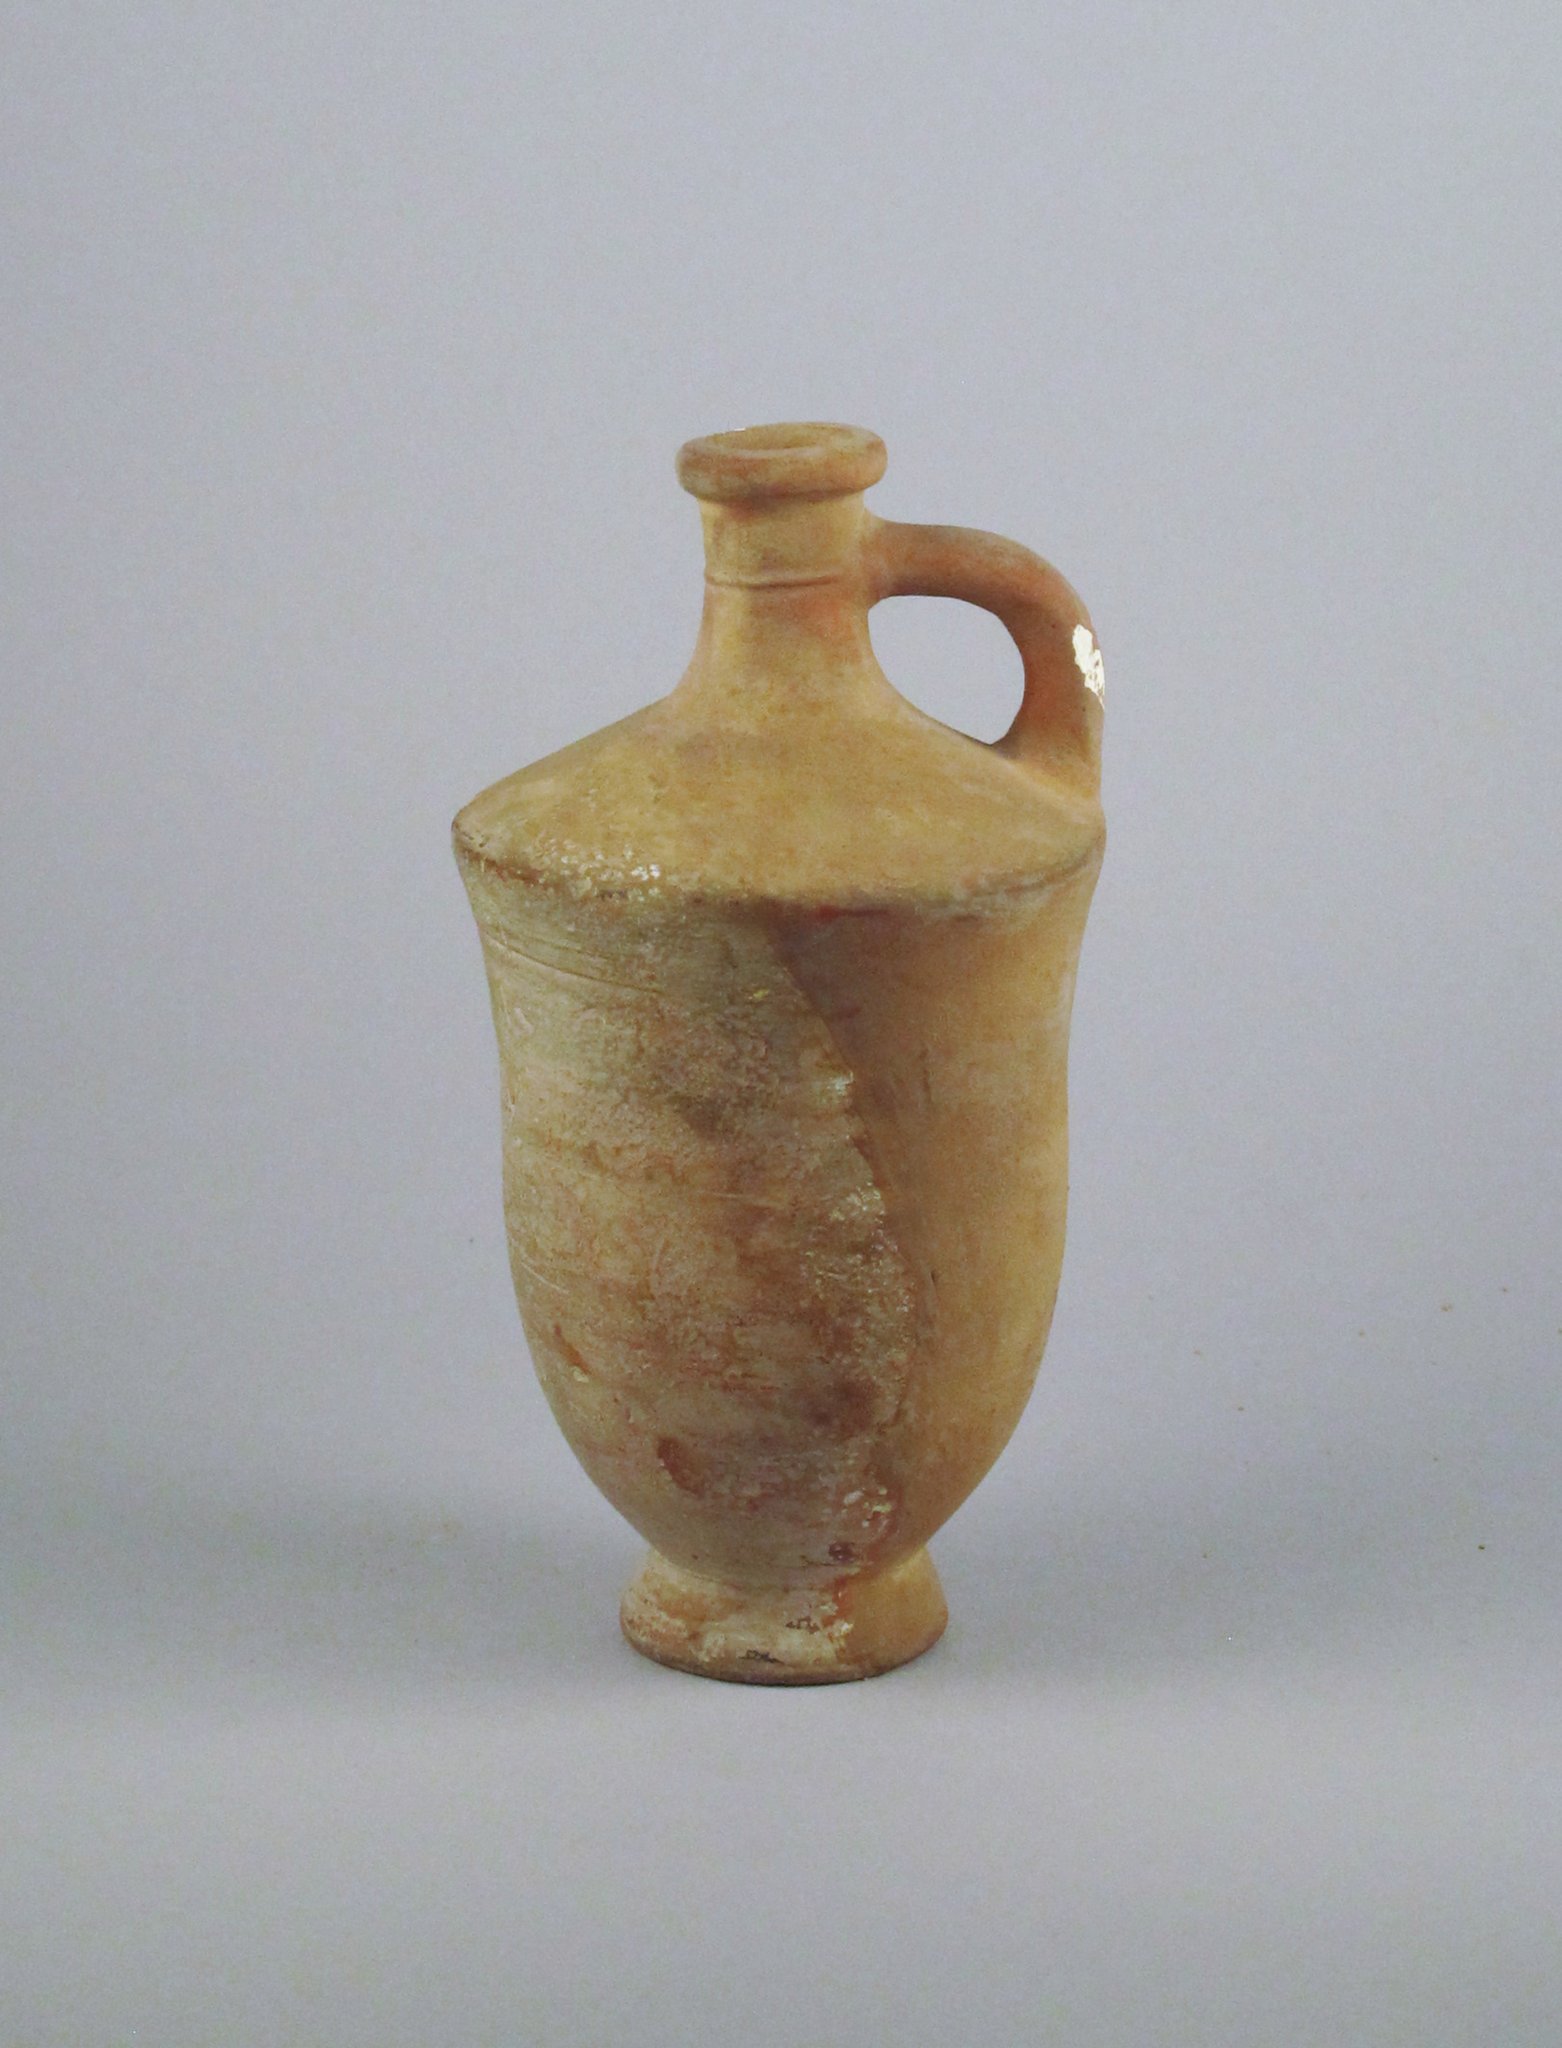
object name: lekythos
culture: greek or lydian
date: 900-30 BCE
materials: terracotta